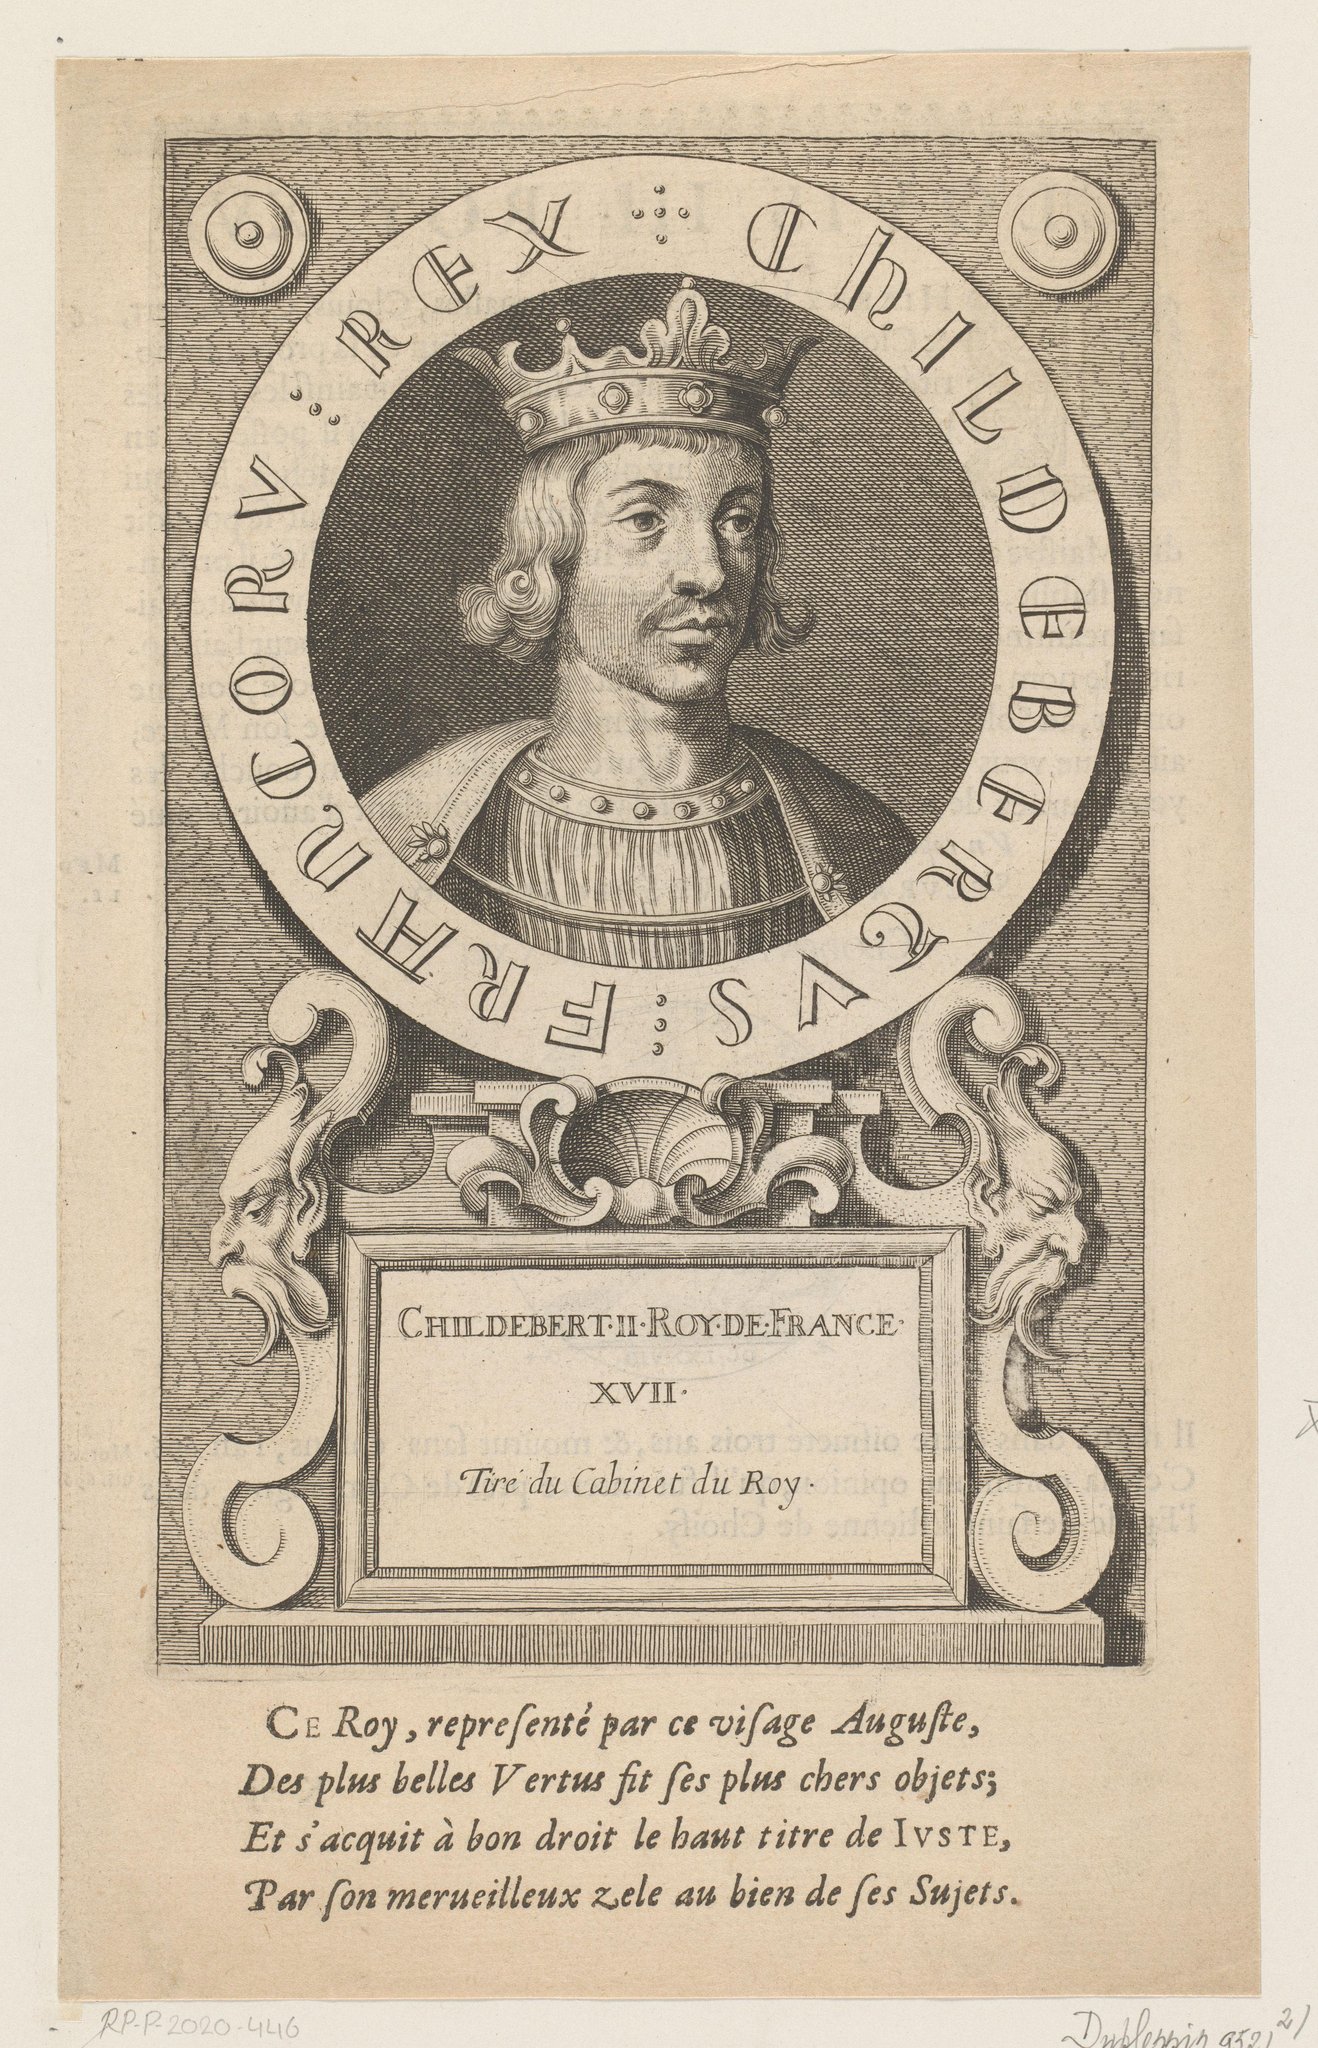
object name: book illustration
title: Portret van Childebert II, koning van Austrasië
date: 1635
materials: paper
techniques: engraving, etching, letterpress printing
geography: paris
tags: historical persons, ruler, sovereign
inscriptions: collector's mark: Lugt 2228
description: Prent uit: Eudes de Mézeray, François. Histoire de France, depuis Faramond jusqu’au regne de Louis le Juste (...). 3 dln. Parijs: Denis Thierry, Jean Guignard en Claude Barbin, 1635, dl. 2. Prent waarschijnlijk voor het eerst verschenen in: Bie, Jacques de. Les vrais portraits des rois de France (...). Parijs: Jacques de Bie en Pierre Rocolet, 1634. Prent ook gebruikt in latere publicaties.